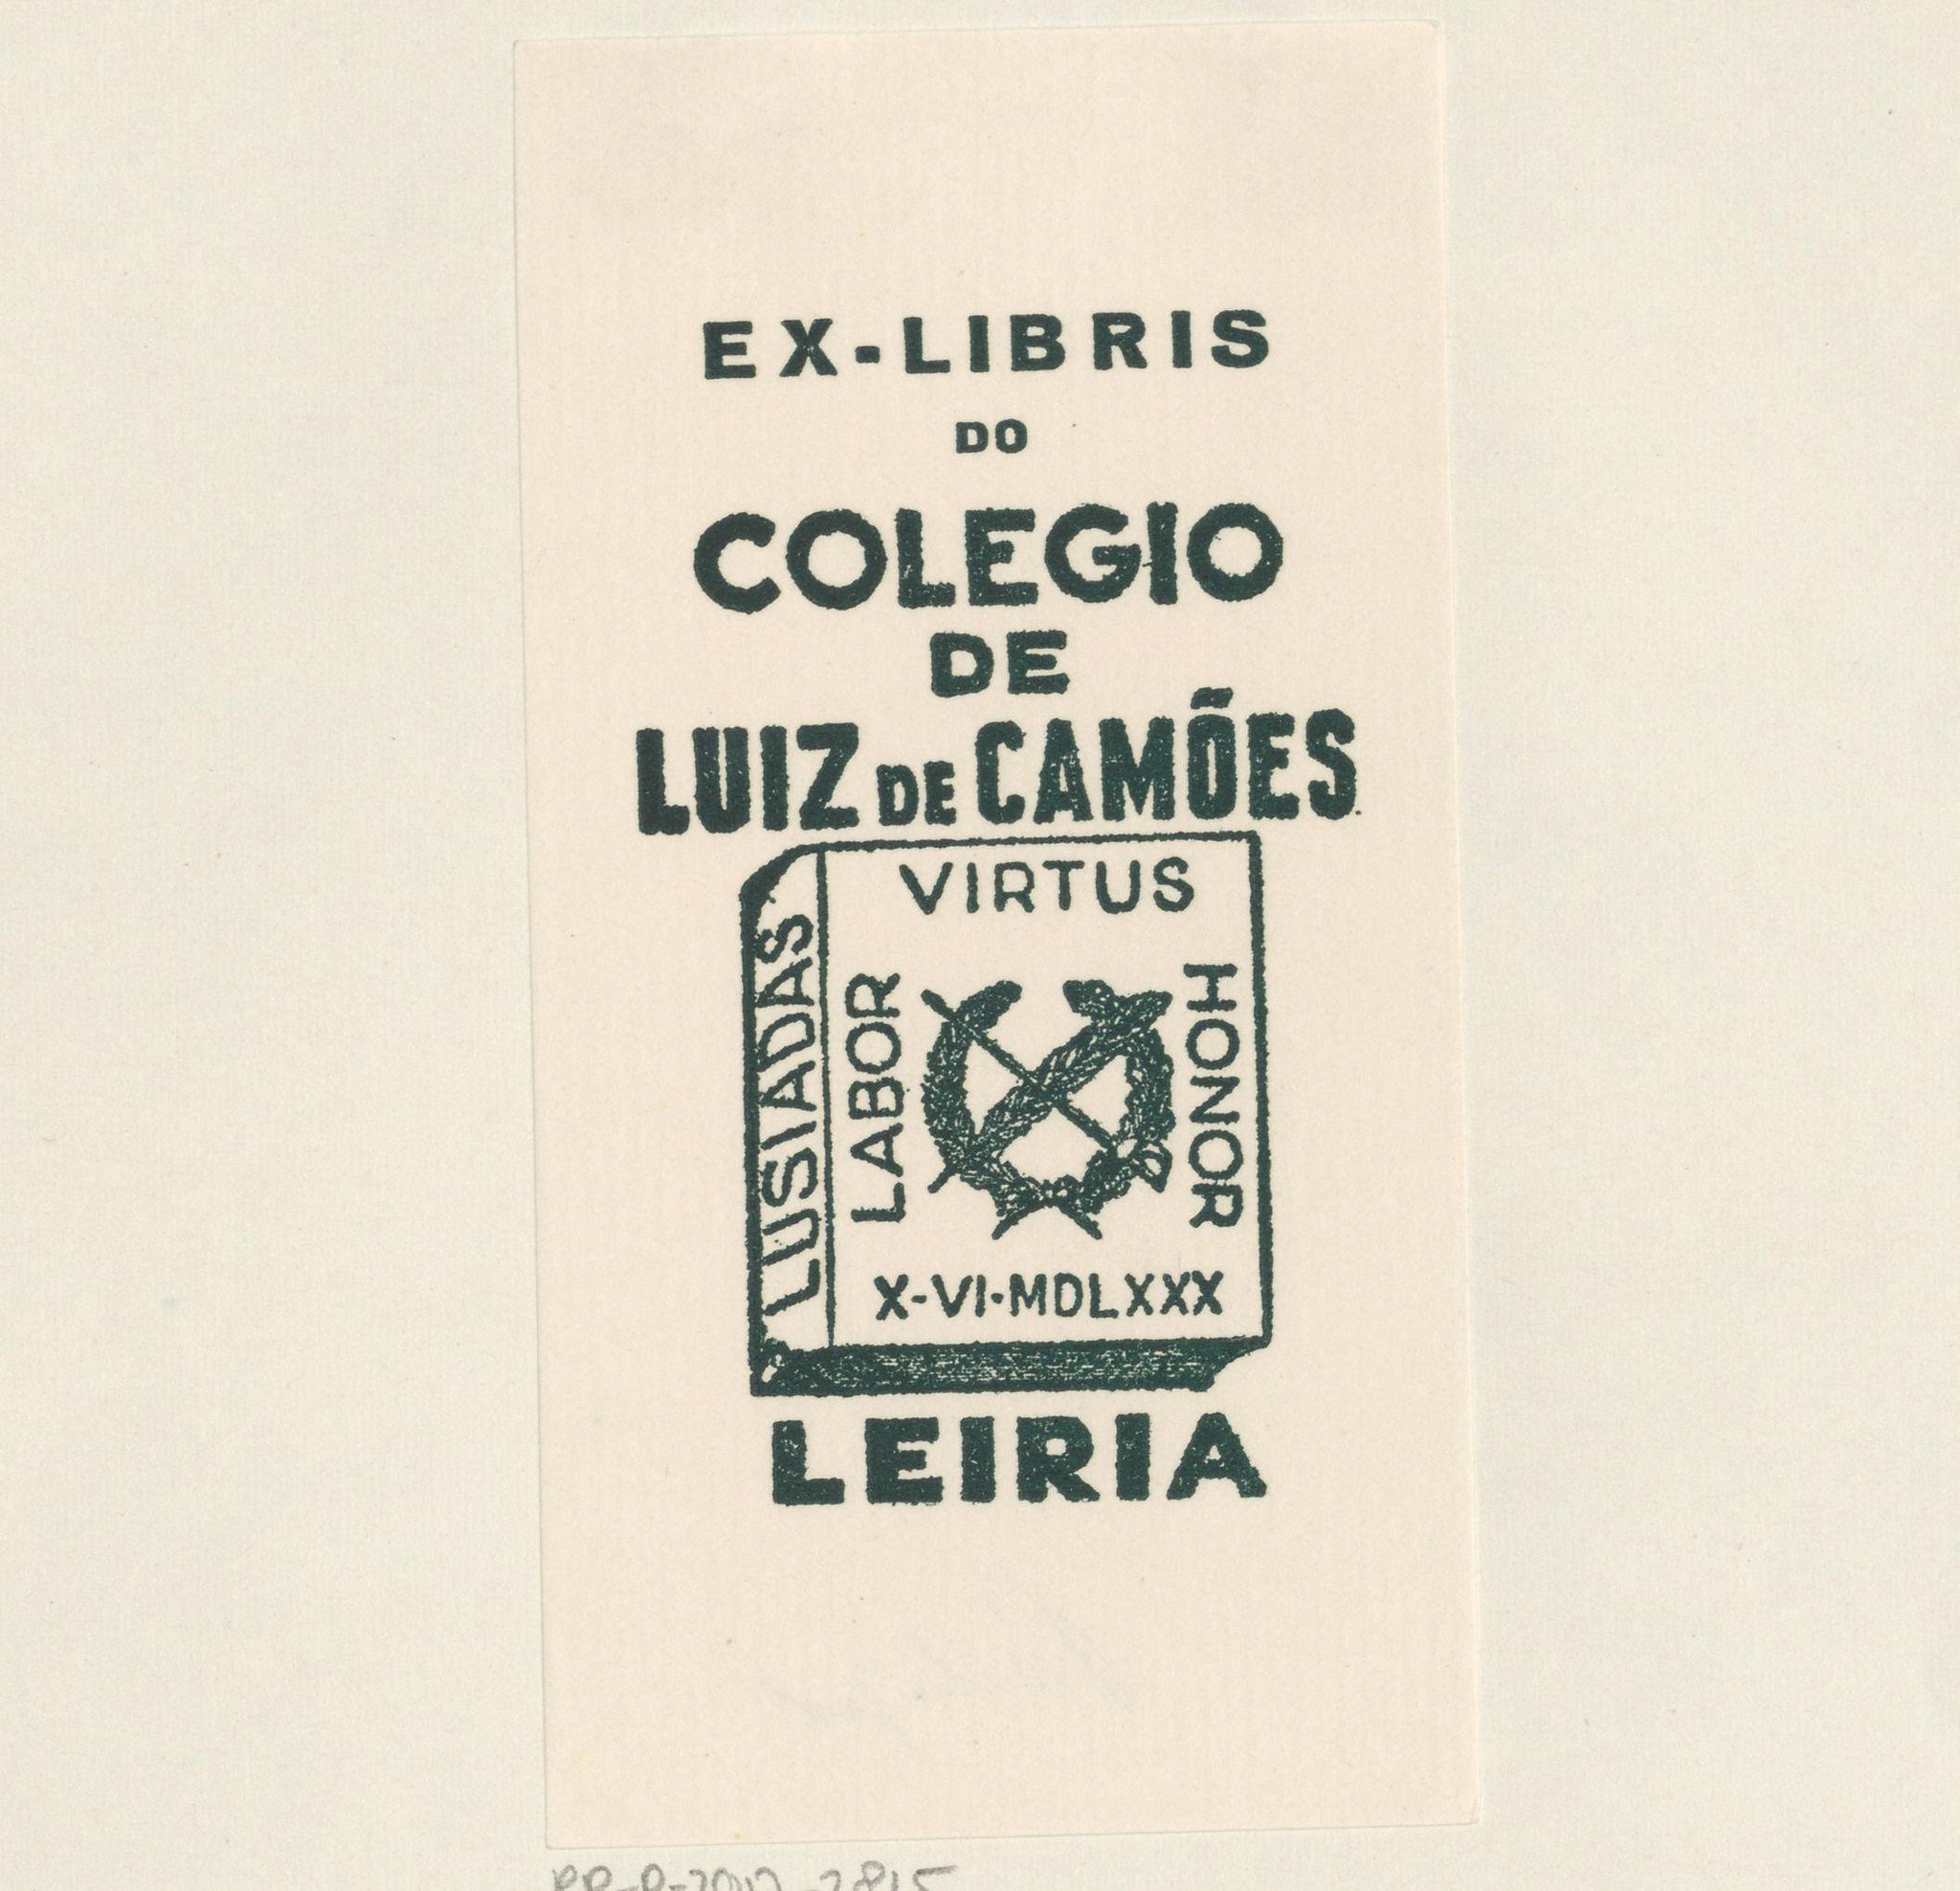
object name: bookplate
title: Ex libris van het Colegio de Luiz de Camões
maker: Anonymous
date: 1930-1950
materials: paper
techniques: lithograph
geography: portugal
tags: quill, garland, wreath, book, hacking and thrusting weapons: rapier